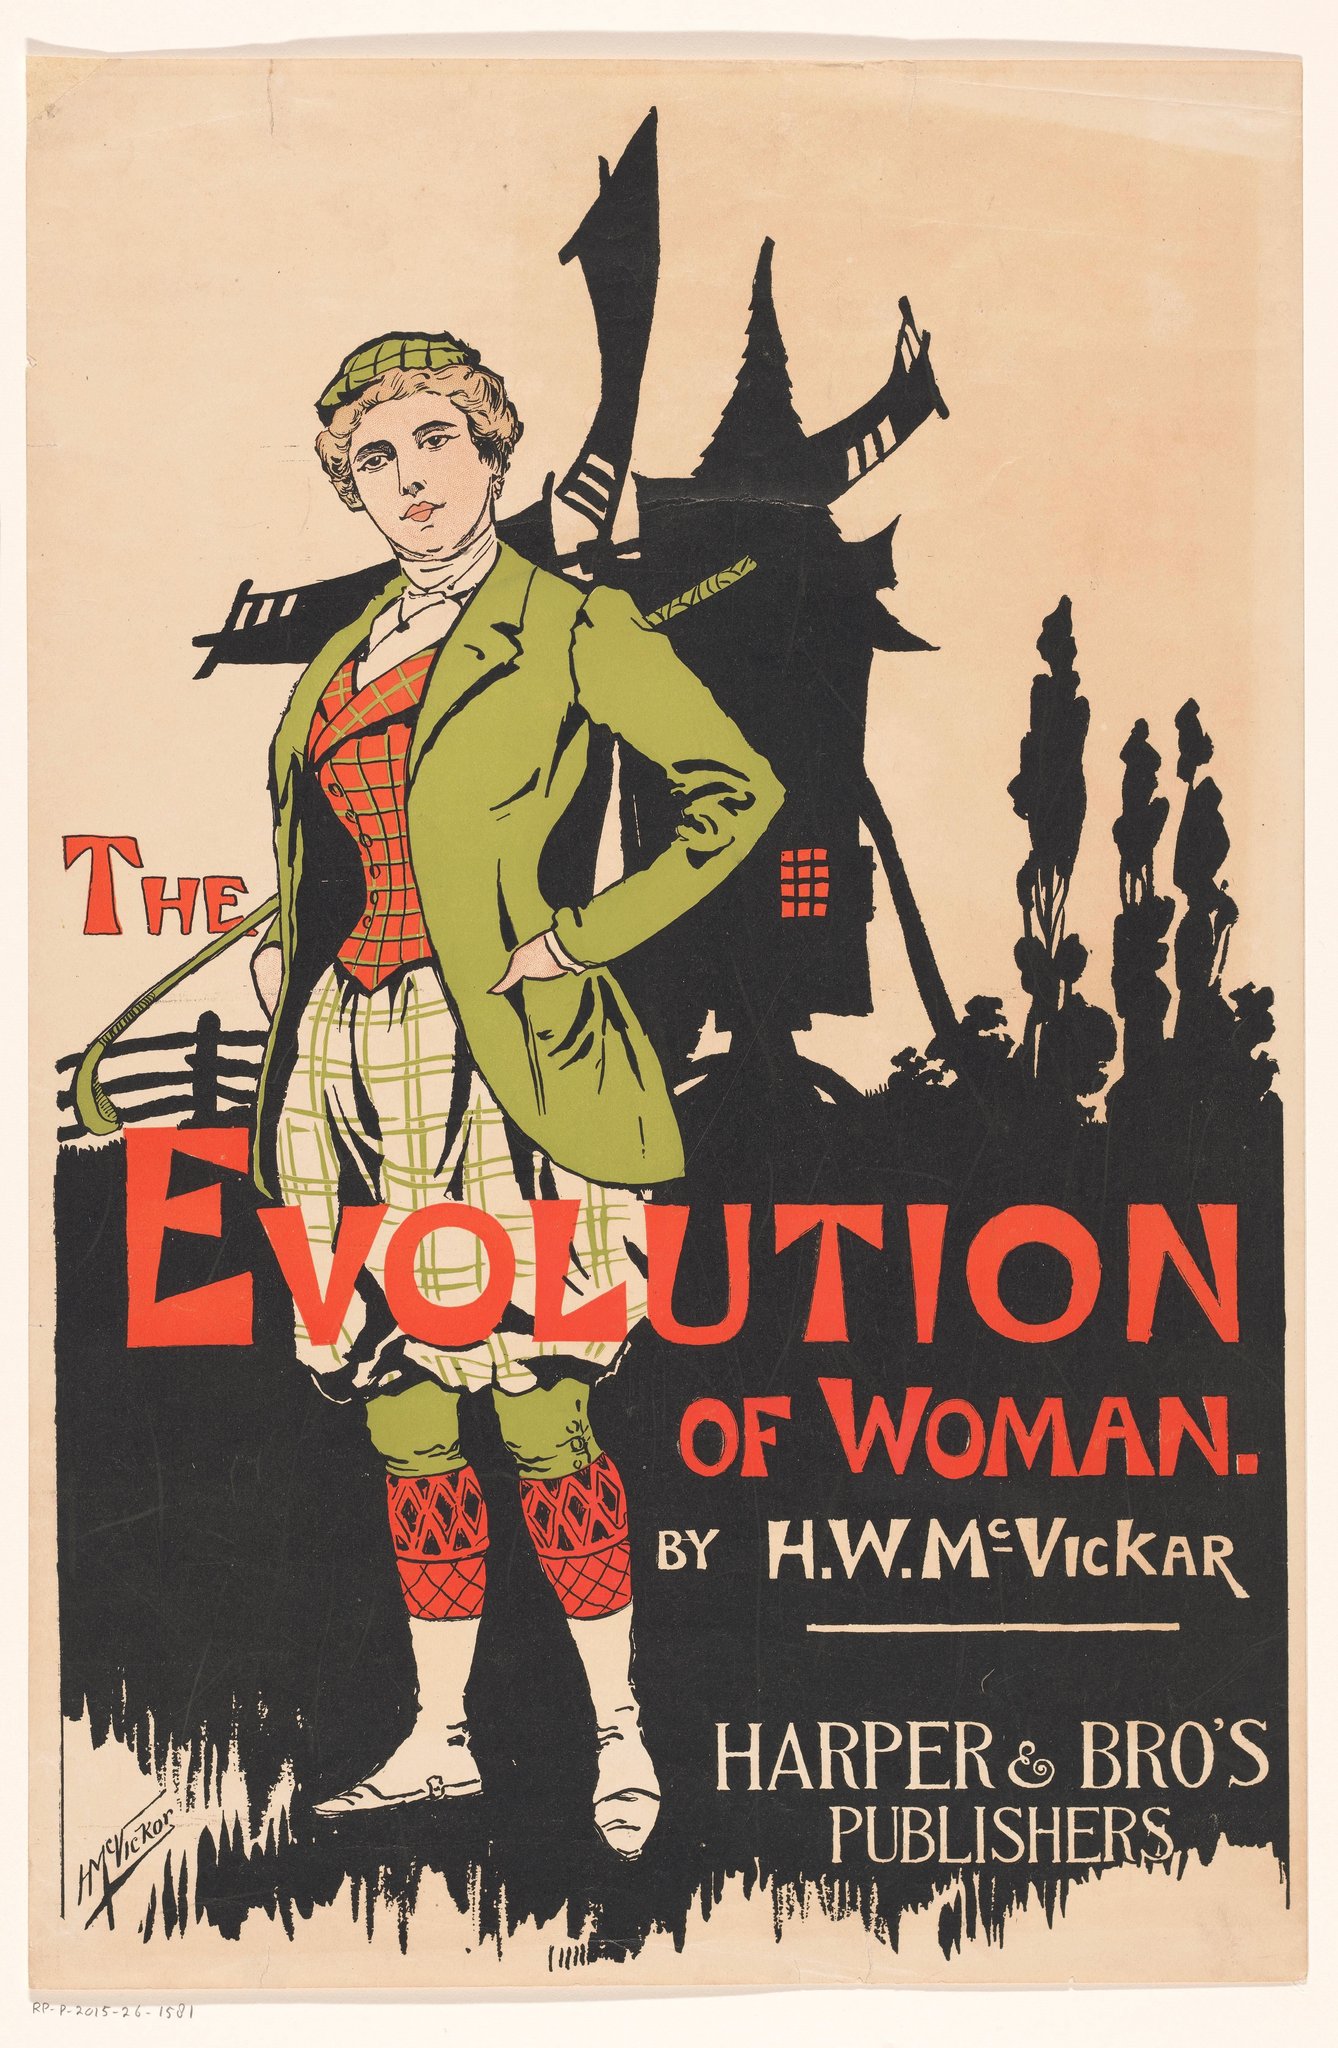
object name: print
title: Reclamebiljet voor The Evolution of Woman door Harry Whitney McVickar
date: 1896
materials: paper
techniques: lithograph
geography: new york city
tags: golf, windmill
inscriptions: collector's mark: Lugt 2228, collector's mark: Lugt 4779, stamp: ‘J. Littauer kunst-Salon Odensplatz 2 München’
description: Reclamebiljet voor: McVickar, Harry Whitney. The Evolution of Woman. New York: Harper & Sons, 1896.